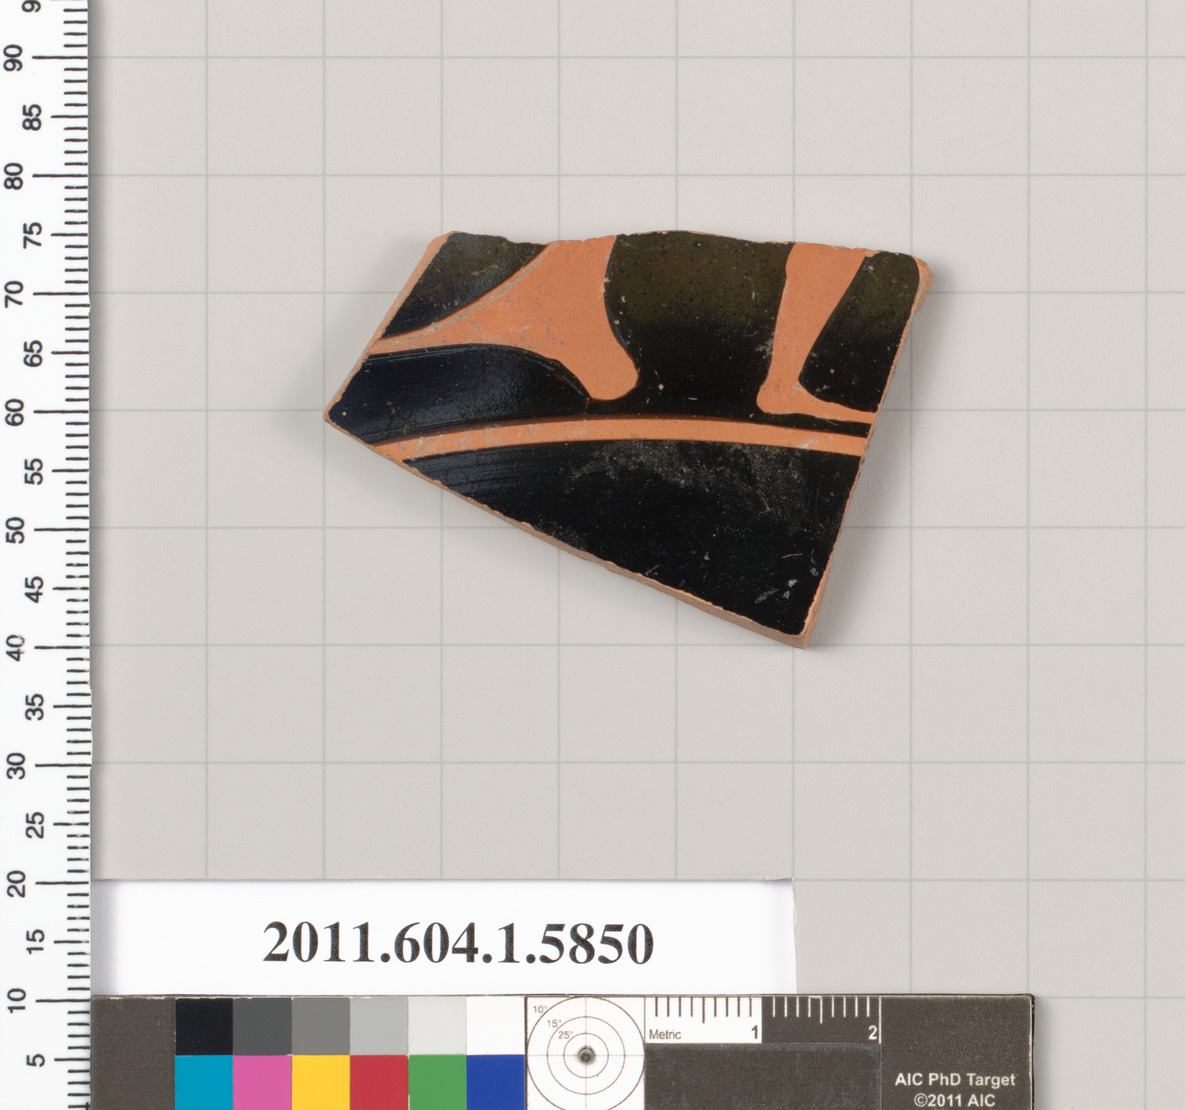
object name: kylix fragment, eye cup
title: Terracotta fragment of a kylix: eye-cup (drinking cup)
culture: greek, attic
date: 433-567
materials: terracotta